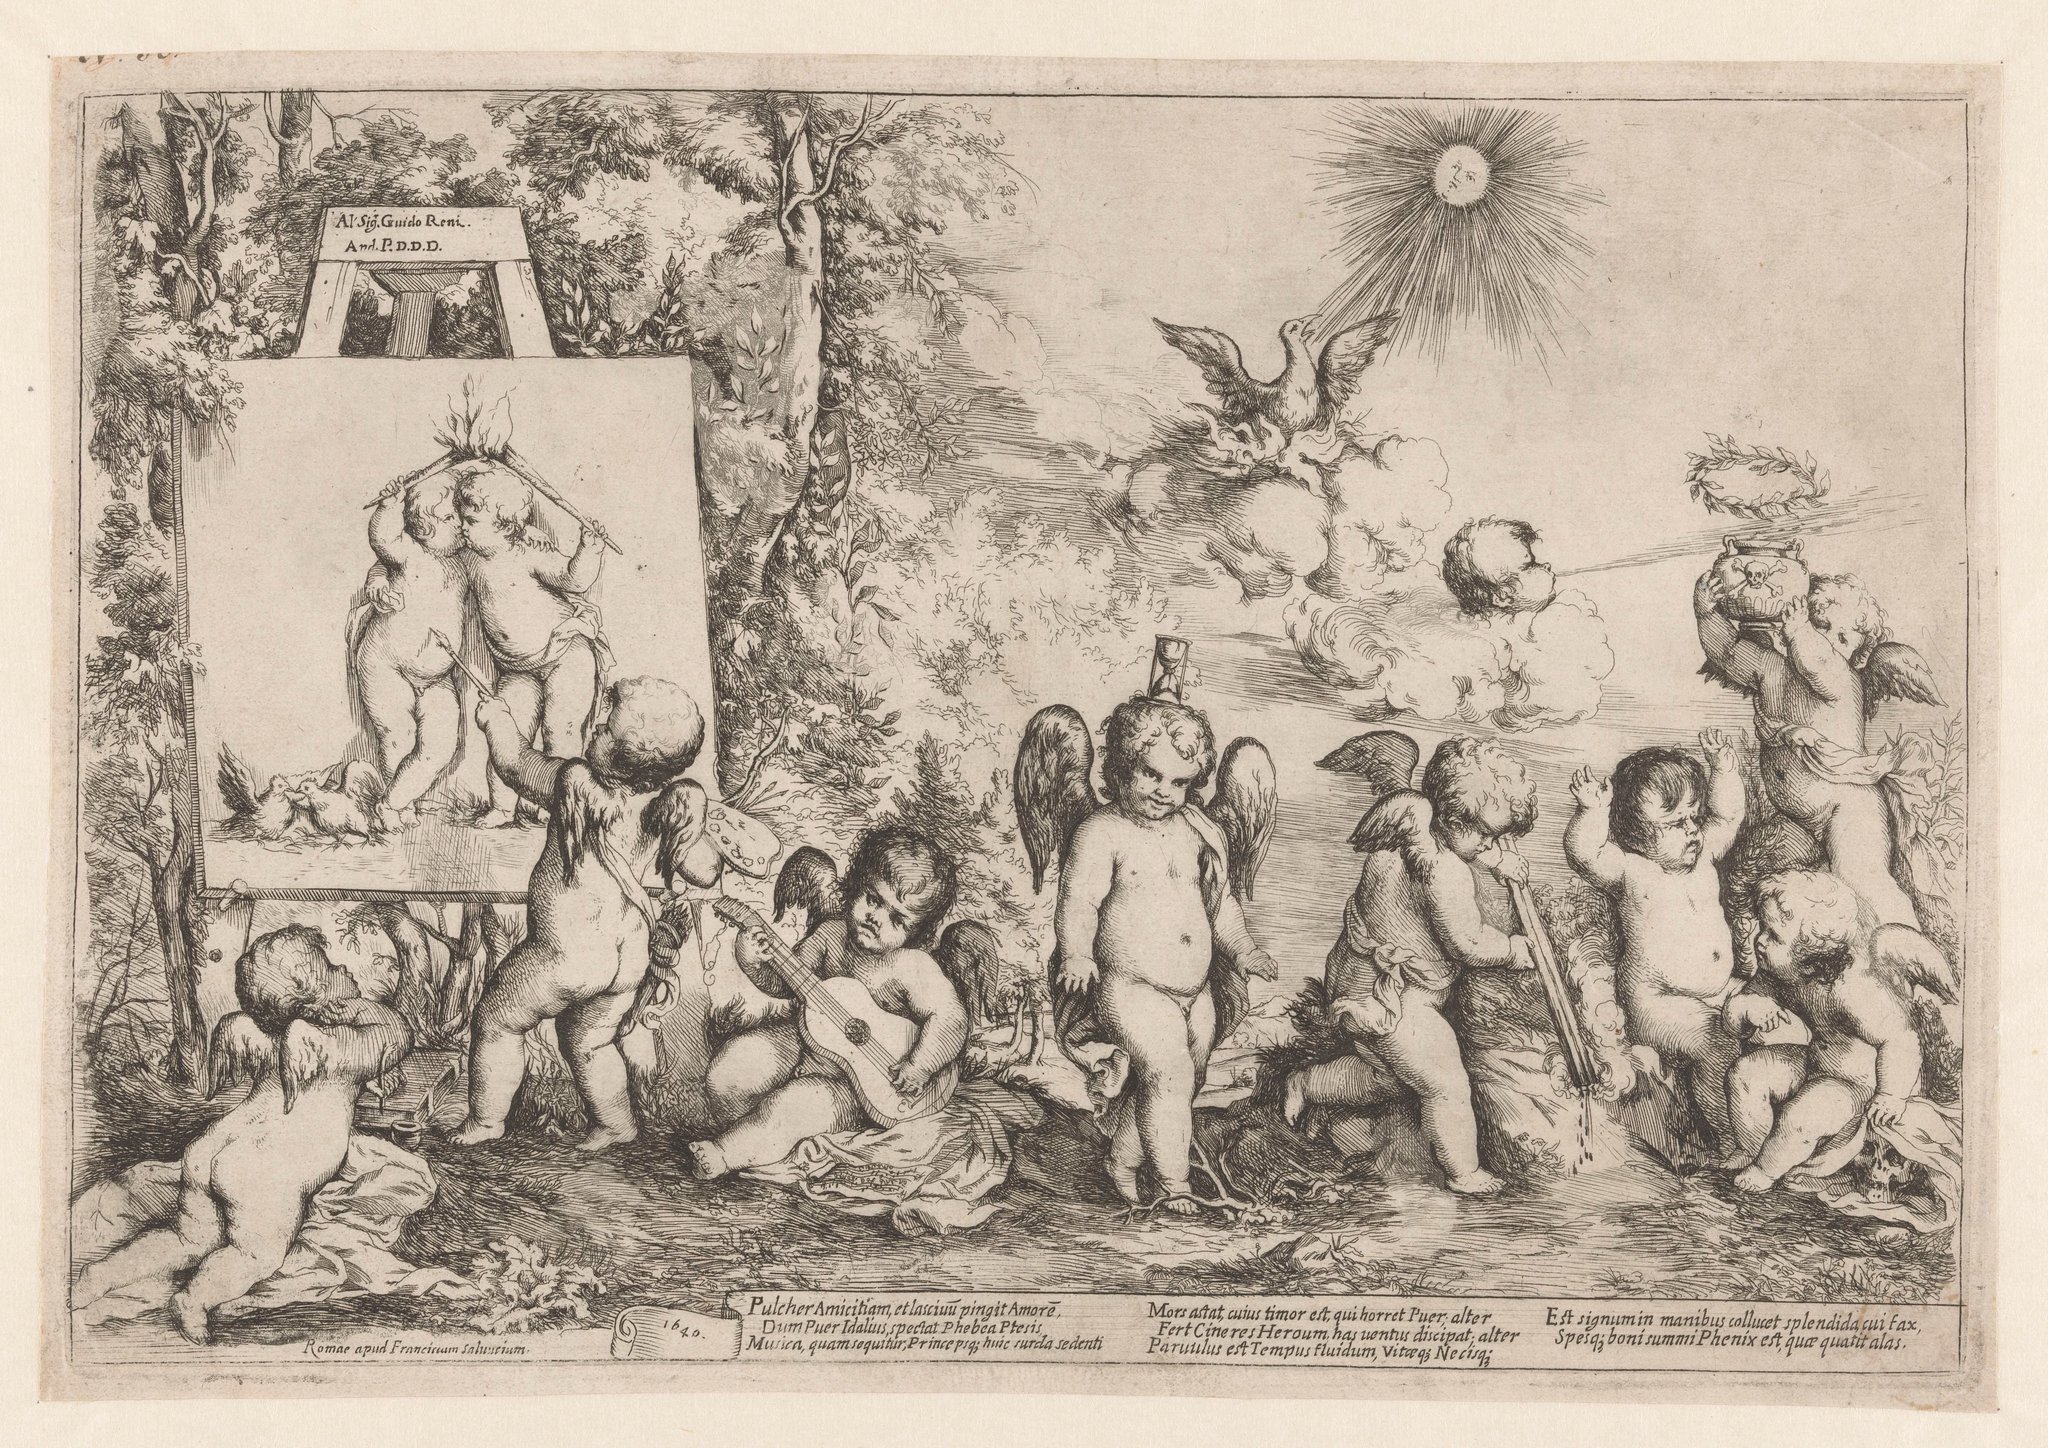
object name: print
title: Allegorie met putti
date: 1640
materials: paper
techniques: etching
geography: italy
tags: cupids: 'amores', 'amoretti', 'putti', fabulous animals ~ birds: phoenix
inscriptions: collector's mark: Lugt 240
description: Allegorische voorstelling met putti. Links Amor die een schilderij maakt met een allegorie op vriendschap en sensuele liefde. Naast hem putti met verschillende attributen, waaronder een gitaar, een schrijfveer, een zandloper en een schedel. In de lucht zweeft een fenix op brandende wolken. Tekst in het Latijn op een banderol rechtsonder.